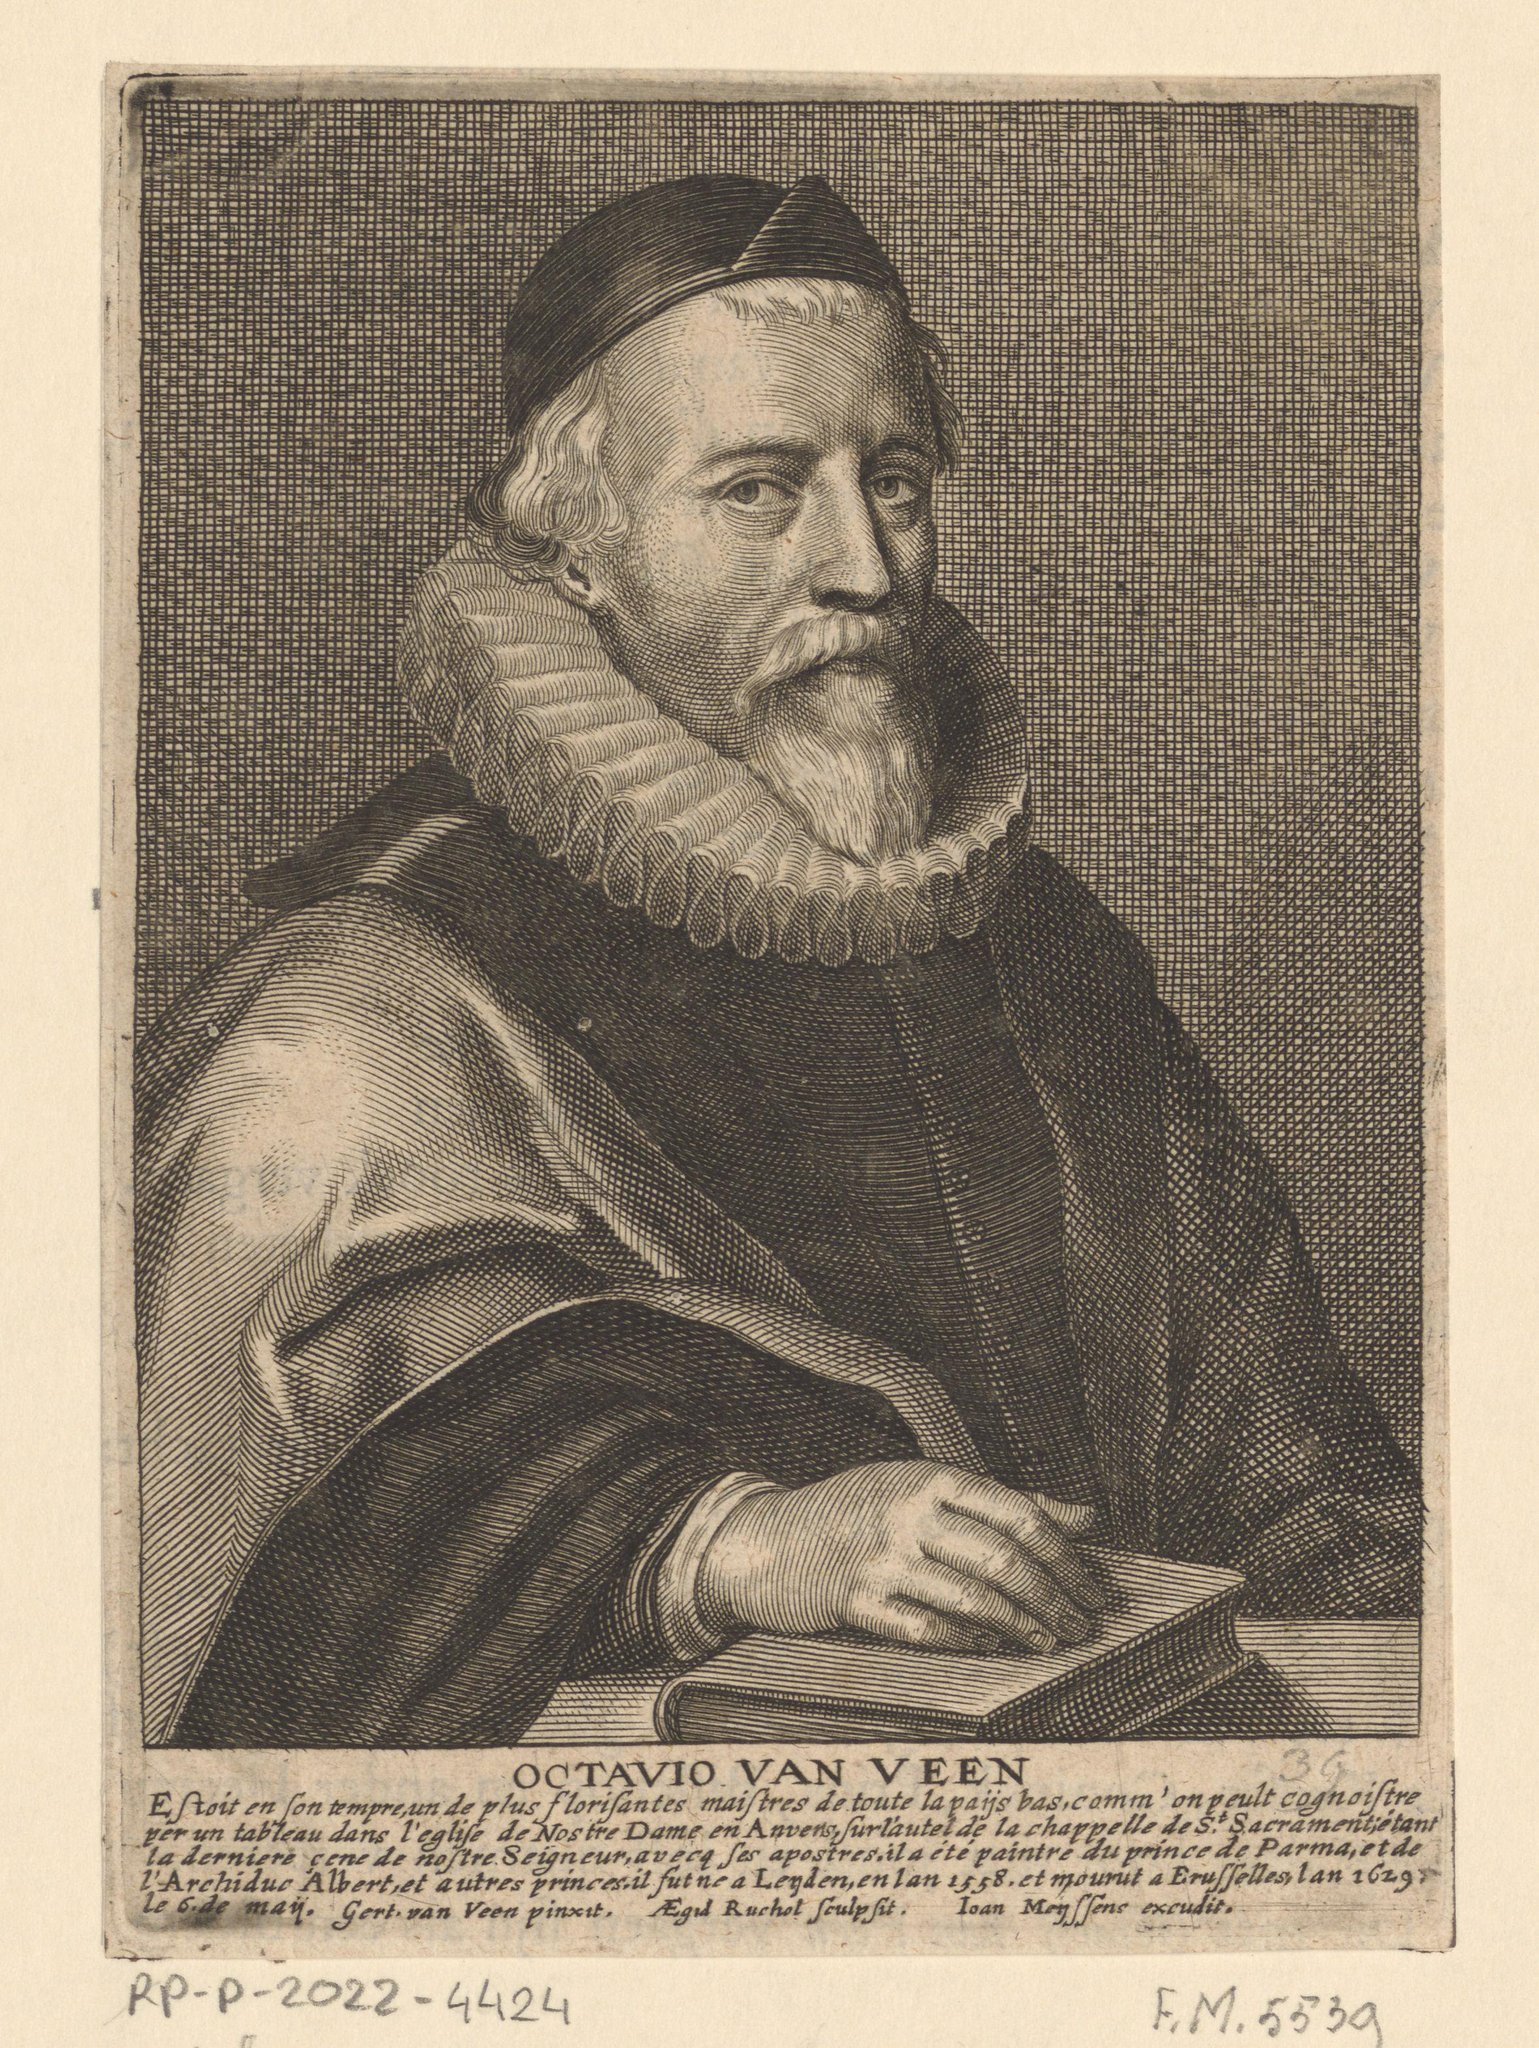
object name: book illustration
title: Portret van Otto van Veen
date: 1661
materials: paper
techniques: engraving, letterpress printing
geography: antwerp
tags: leiden, brussels, painter, draughtsman, otto van veen, historical persons, portrait, self-portrait of painter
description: Prent uit: Bie, Cornelis de. Het gulden Cabinet vande edel vry schilder const (...). Antwerpen: Joannes Meyssens, 1661.